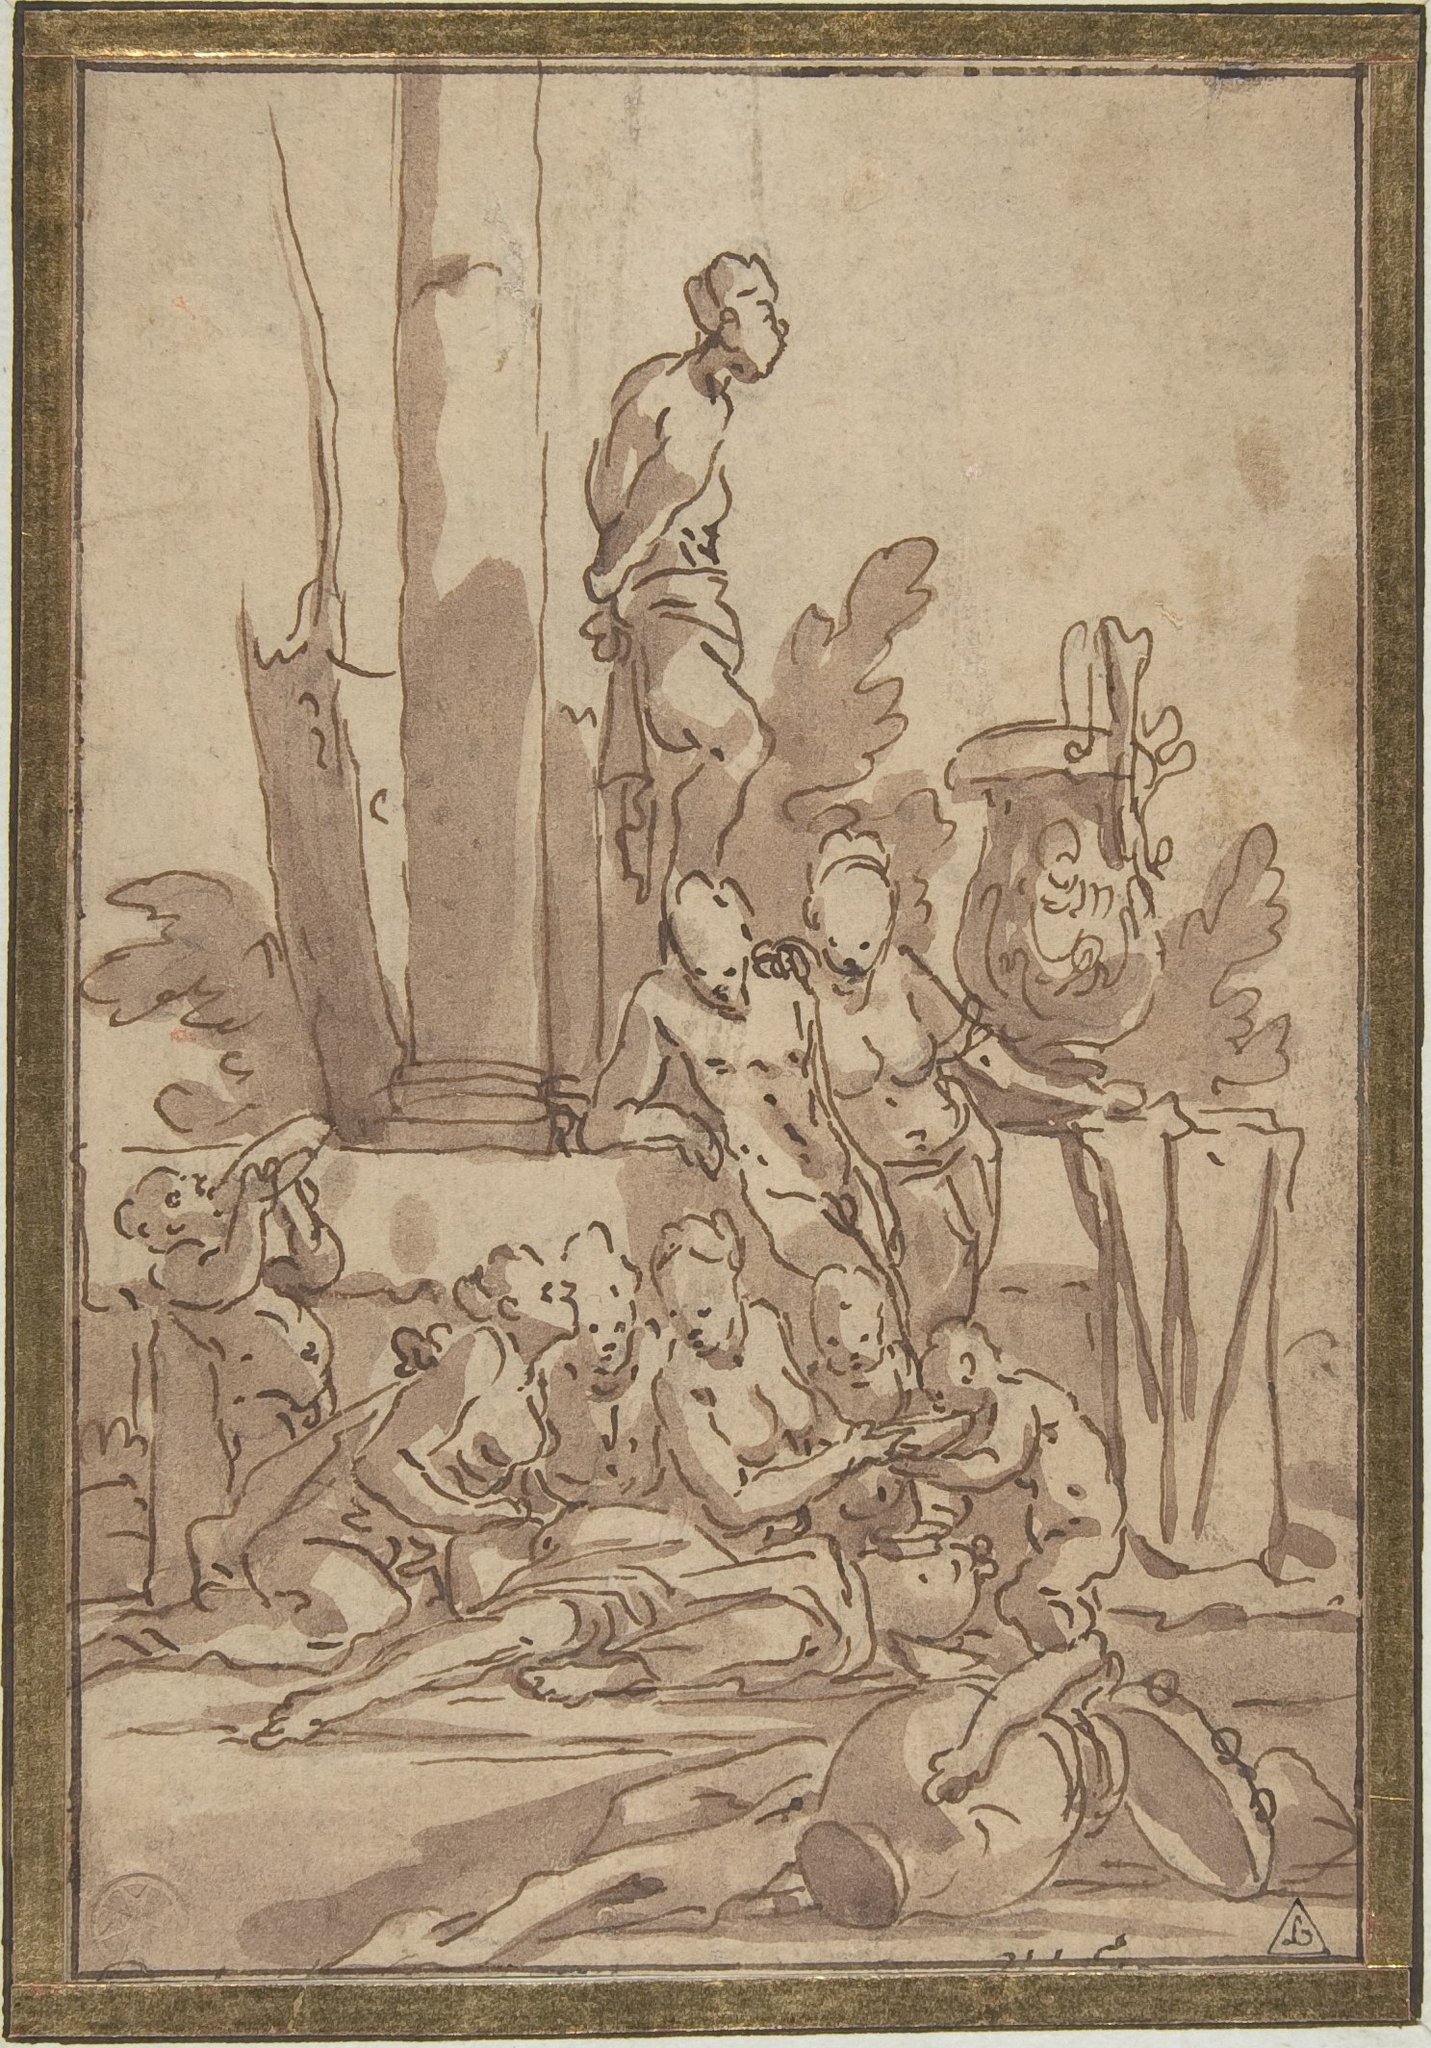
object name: drawing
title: Bacchanalian Group with Children Drinking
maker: giulio carpioni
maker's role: artist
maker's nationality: italian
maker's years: 1613-1678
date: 1613-1678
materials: ink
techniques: brush, pen, wash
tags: men,female nudes